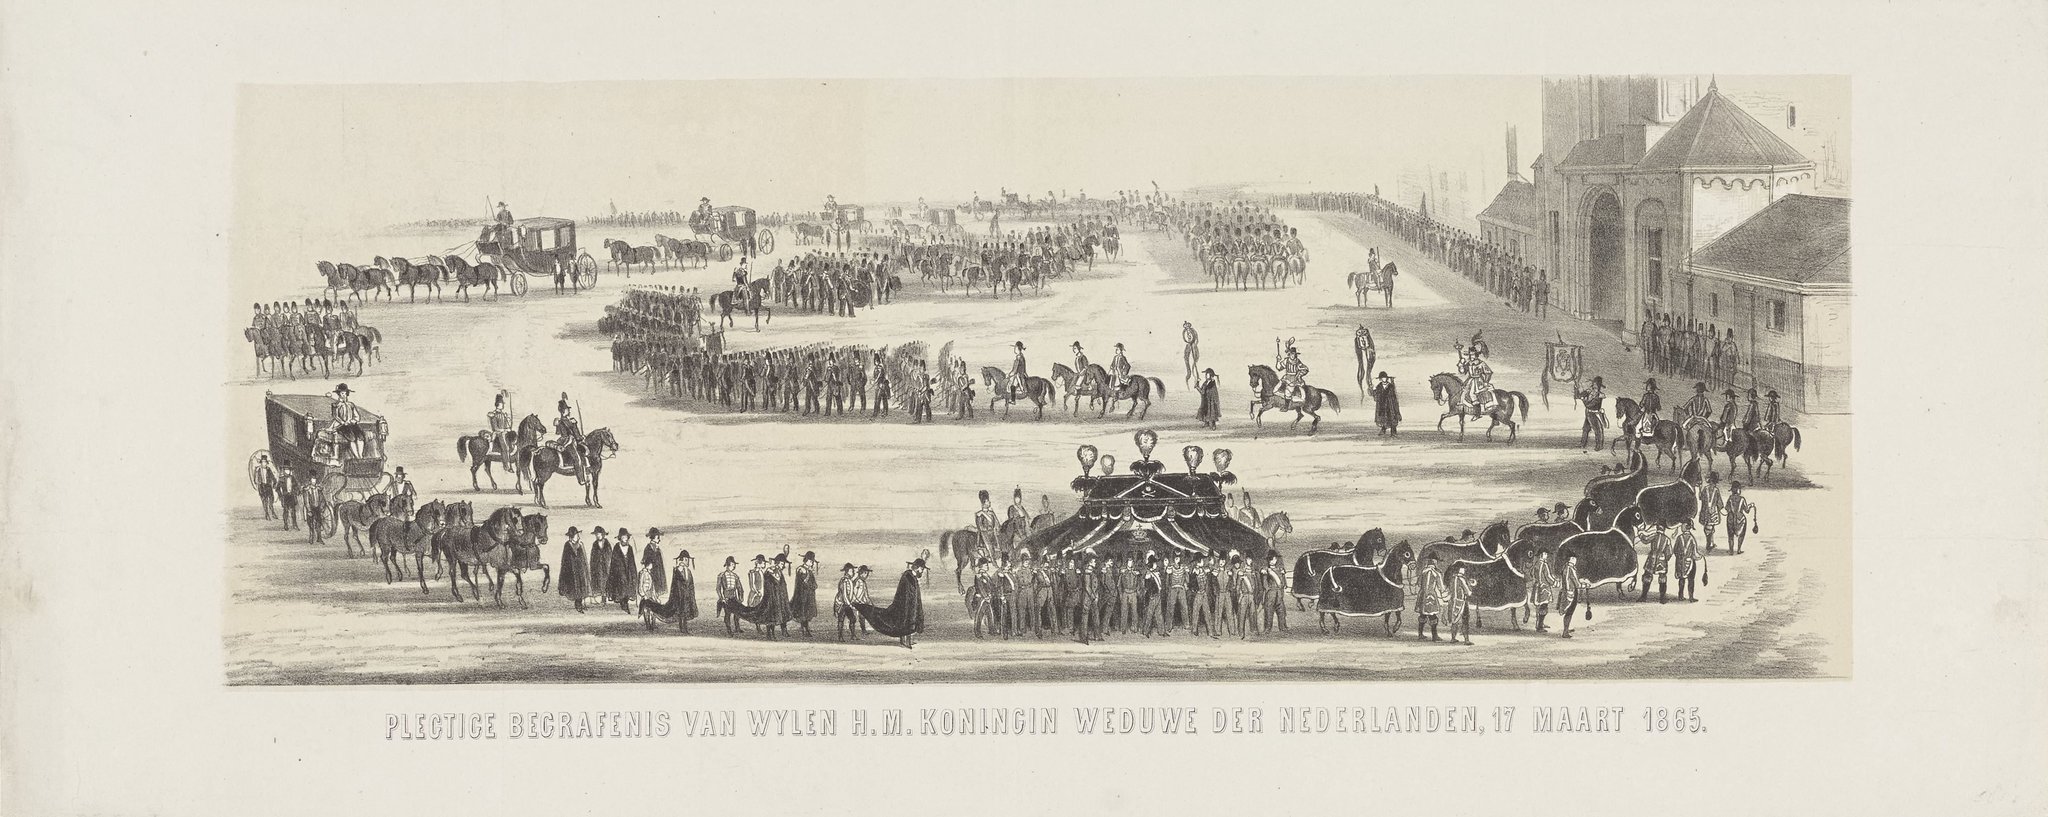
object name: print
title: Plegtige begrafenis van wylen H.M. Koningin weduwe der Nederlanden, 17 Maart 1865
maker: Anonymous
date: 1865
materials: paper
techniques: tone lithography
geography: netherlands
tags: the hague, anna paulowna romanowa, cortege, funeral procession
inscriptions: collector's mark: Lugt 2228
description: Begrafenisstoet van wijlen koningin Anna Paulowna, overleden op 1 maart, op de Grote Markt voor de Nieuwe Kerk te Delft op 17 maart 1865.